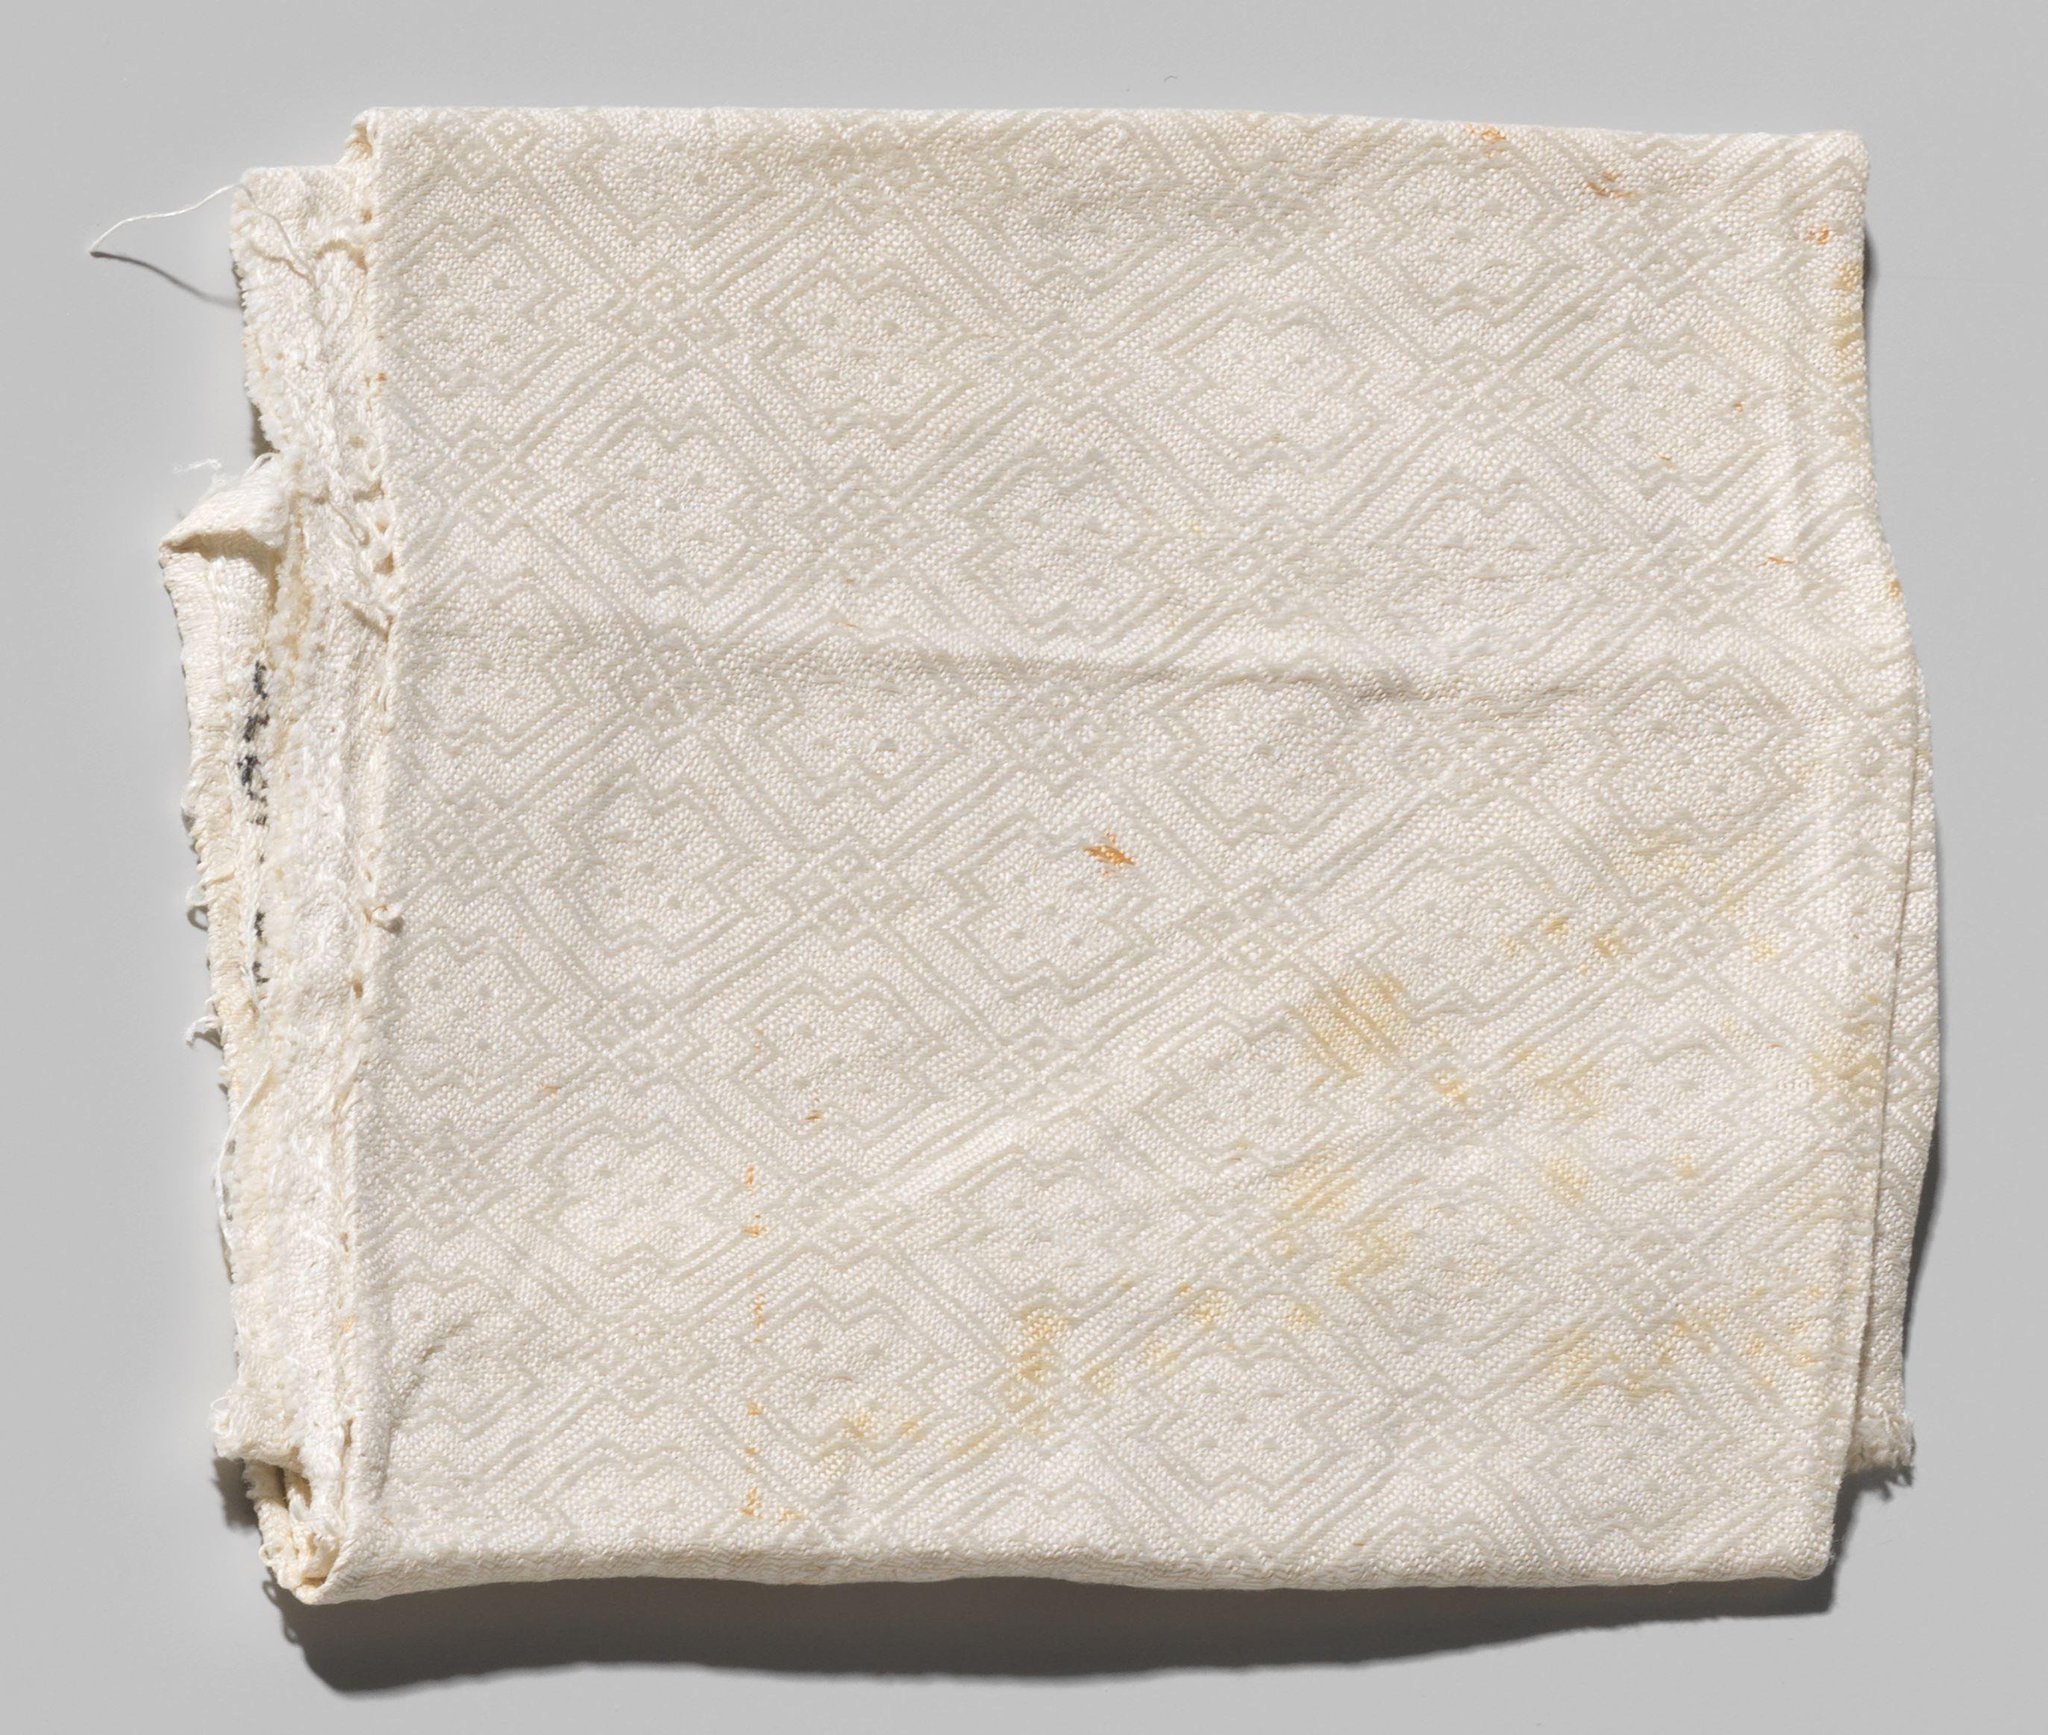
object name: napkin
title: Servet, fragment, met patroon van traliewerk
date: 1600-1699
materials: linen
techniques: peeled fabric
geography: netherlands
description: Servet, fragment van wit linnendamast met een patroon van traliewerk van dubbele lijnen die op de snijpunten overgaan in ruiten. Vullingen van een kort dit kruis waarin vijf punten.